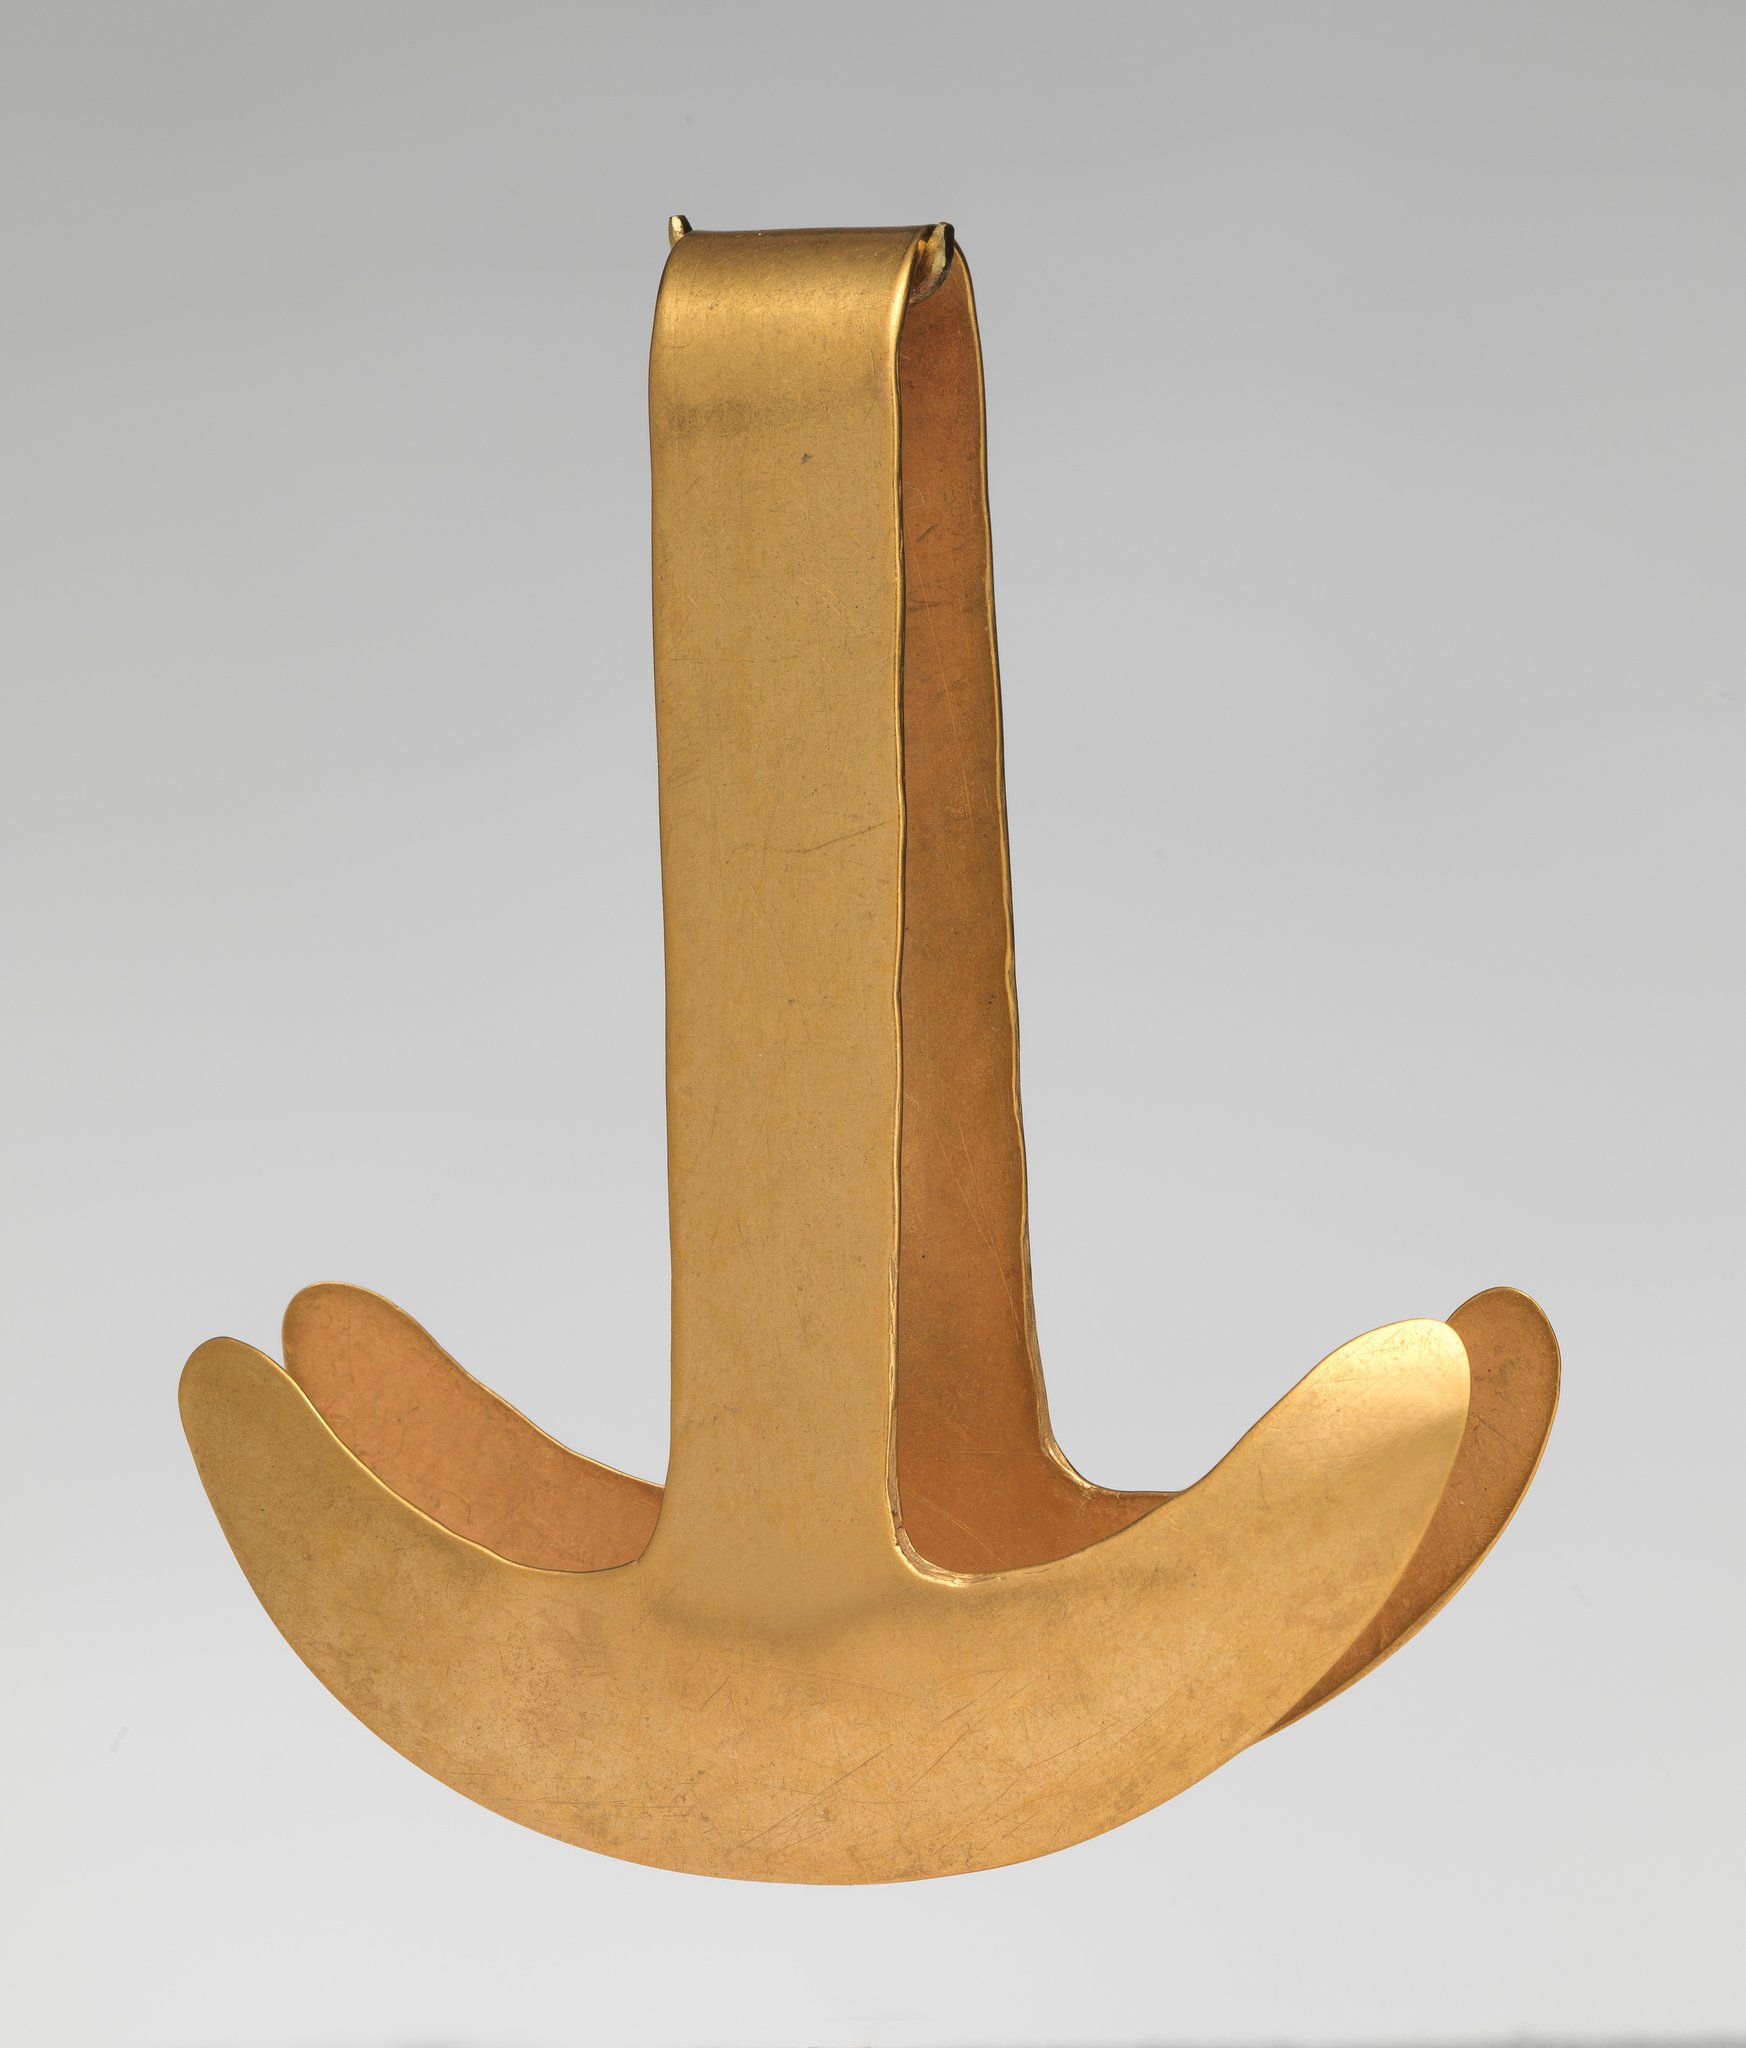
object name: tweezer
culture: calima or yotoco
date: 1-700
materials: gold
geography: colombia